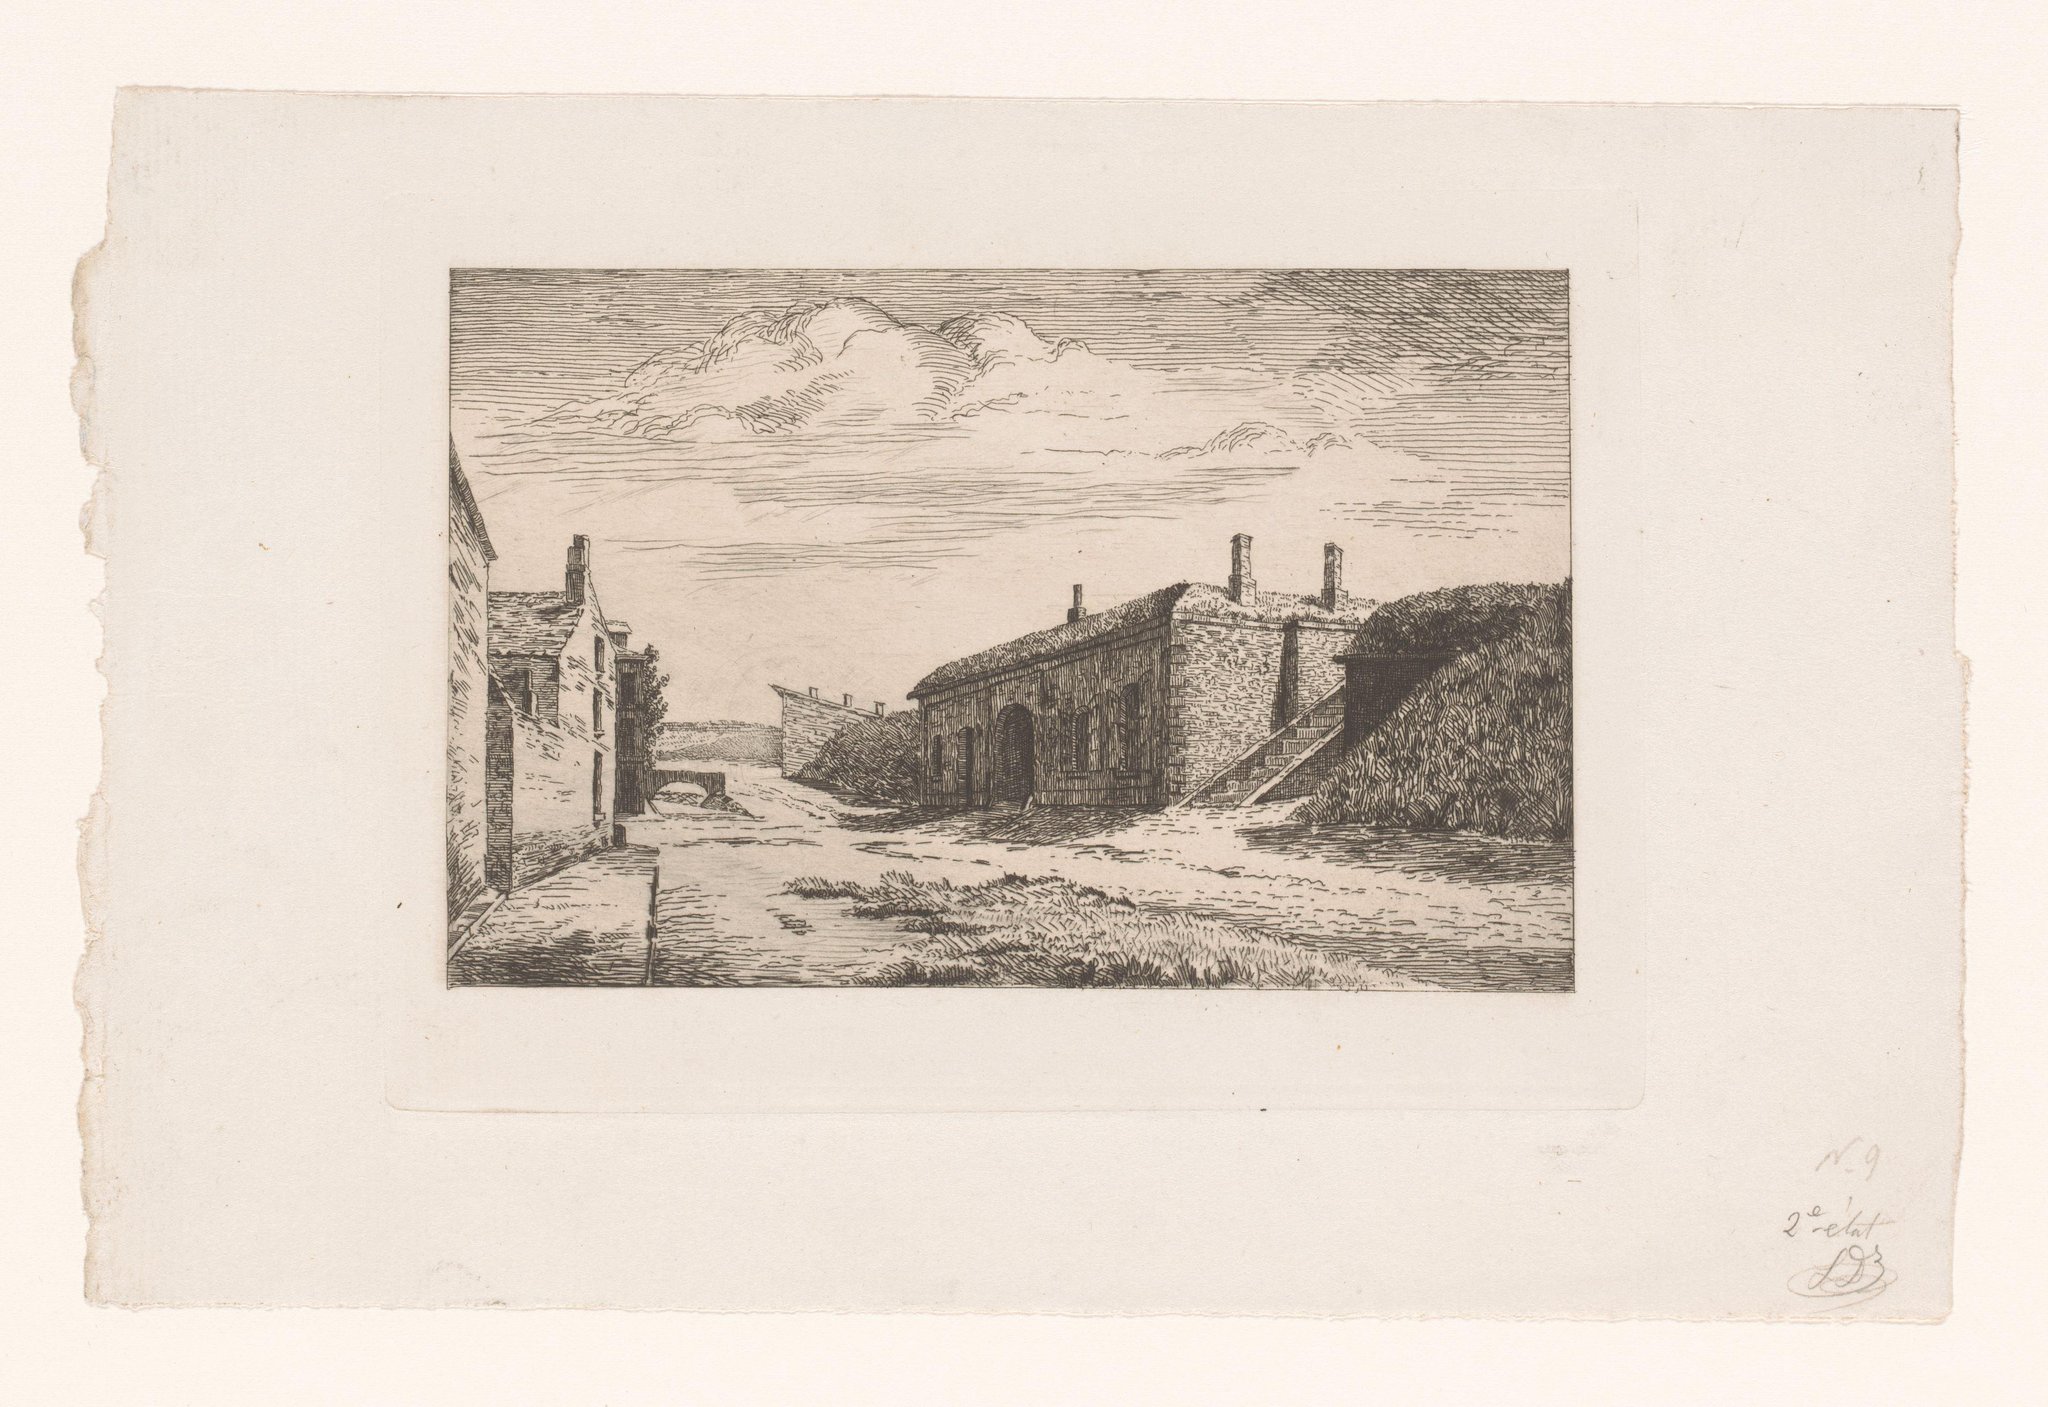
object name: print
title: Gezicht op de poort van Bertaimont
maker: léon dolez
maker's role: print maker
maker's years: 1837-1902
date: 1875-1878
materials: paper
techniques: etching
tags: city-gate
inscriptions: collector's mark: Lugt 2228, inscription: ‘2e état’